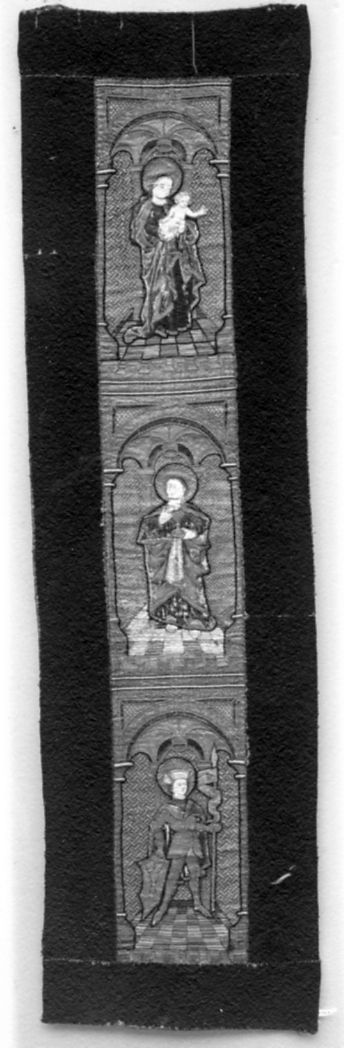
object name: orphrey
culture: german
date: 1401-1500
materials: silk, thread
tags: soldiers,shields,spears,madonna and child